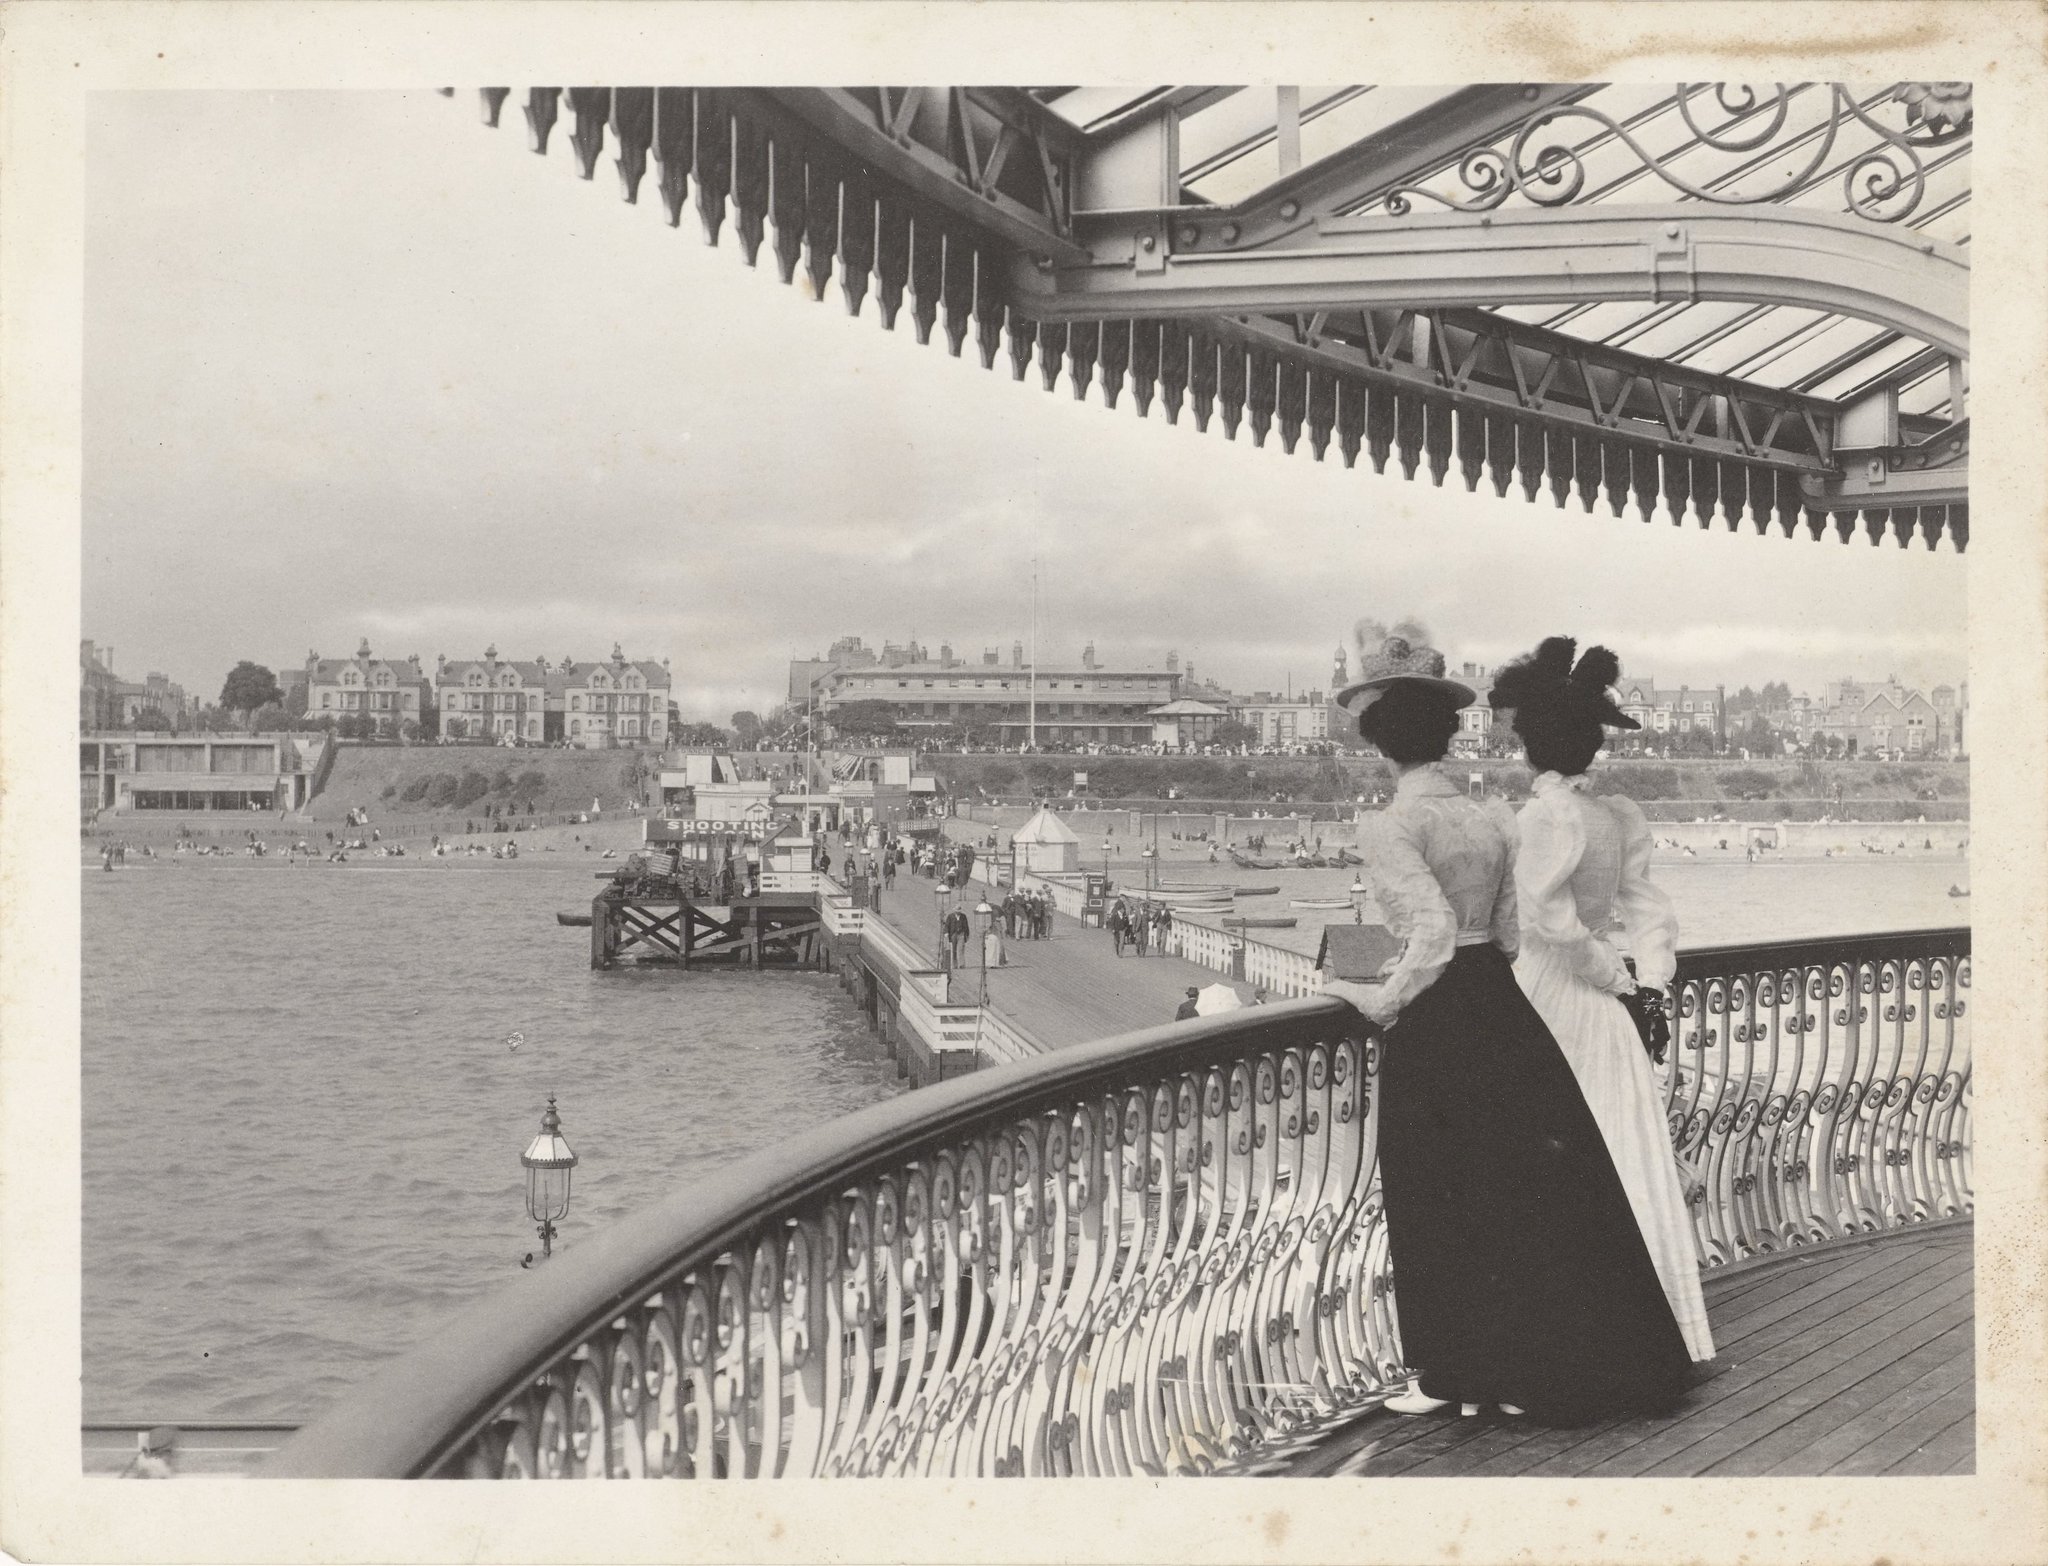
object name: photograph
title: Clacton on Sea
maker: Anonymous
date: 1899-1903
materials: photographic support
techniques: platinum process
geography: clacton-on-sea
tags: adult woman, pier, quay, wharf